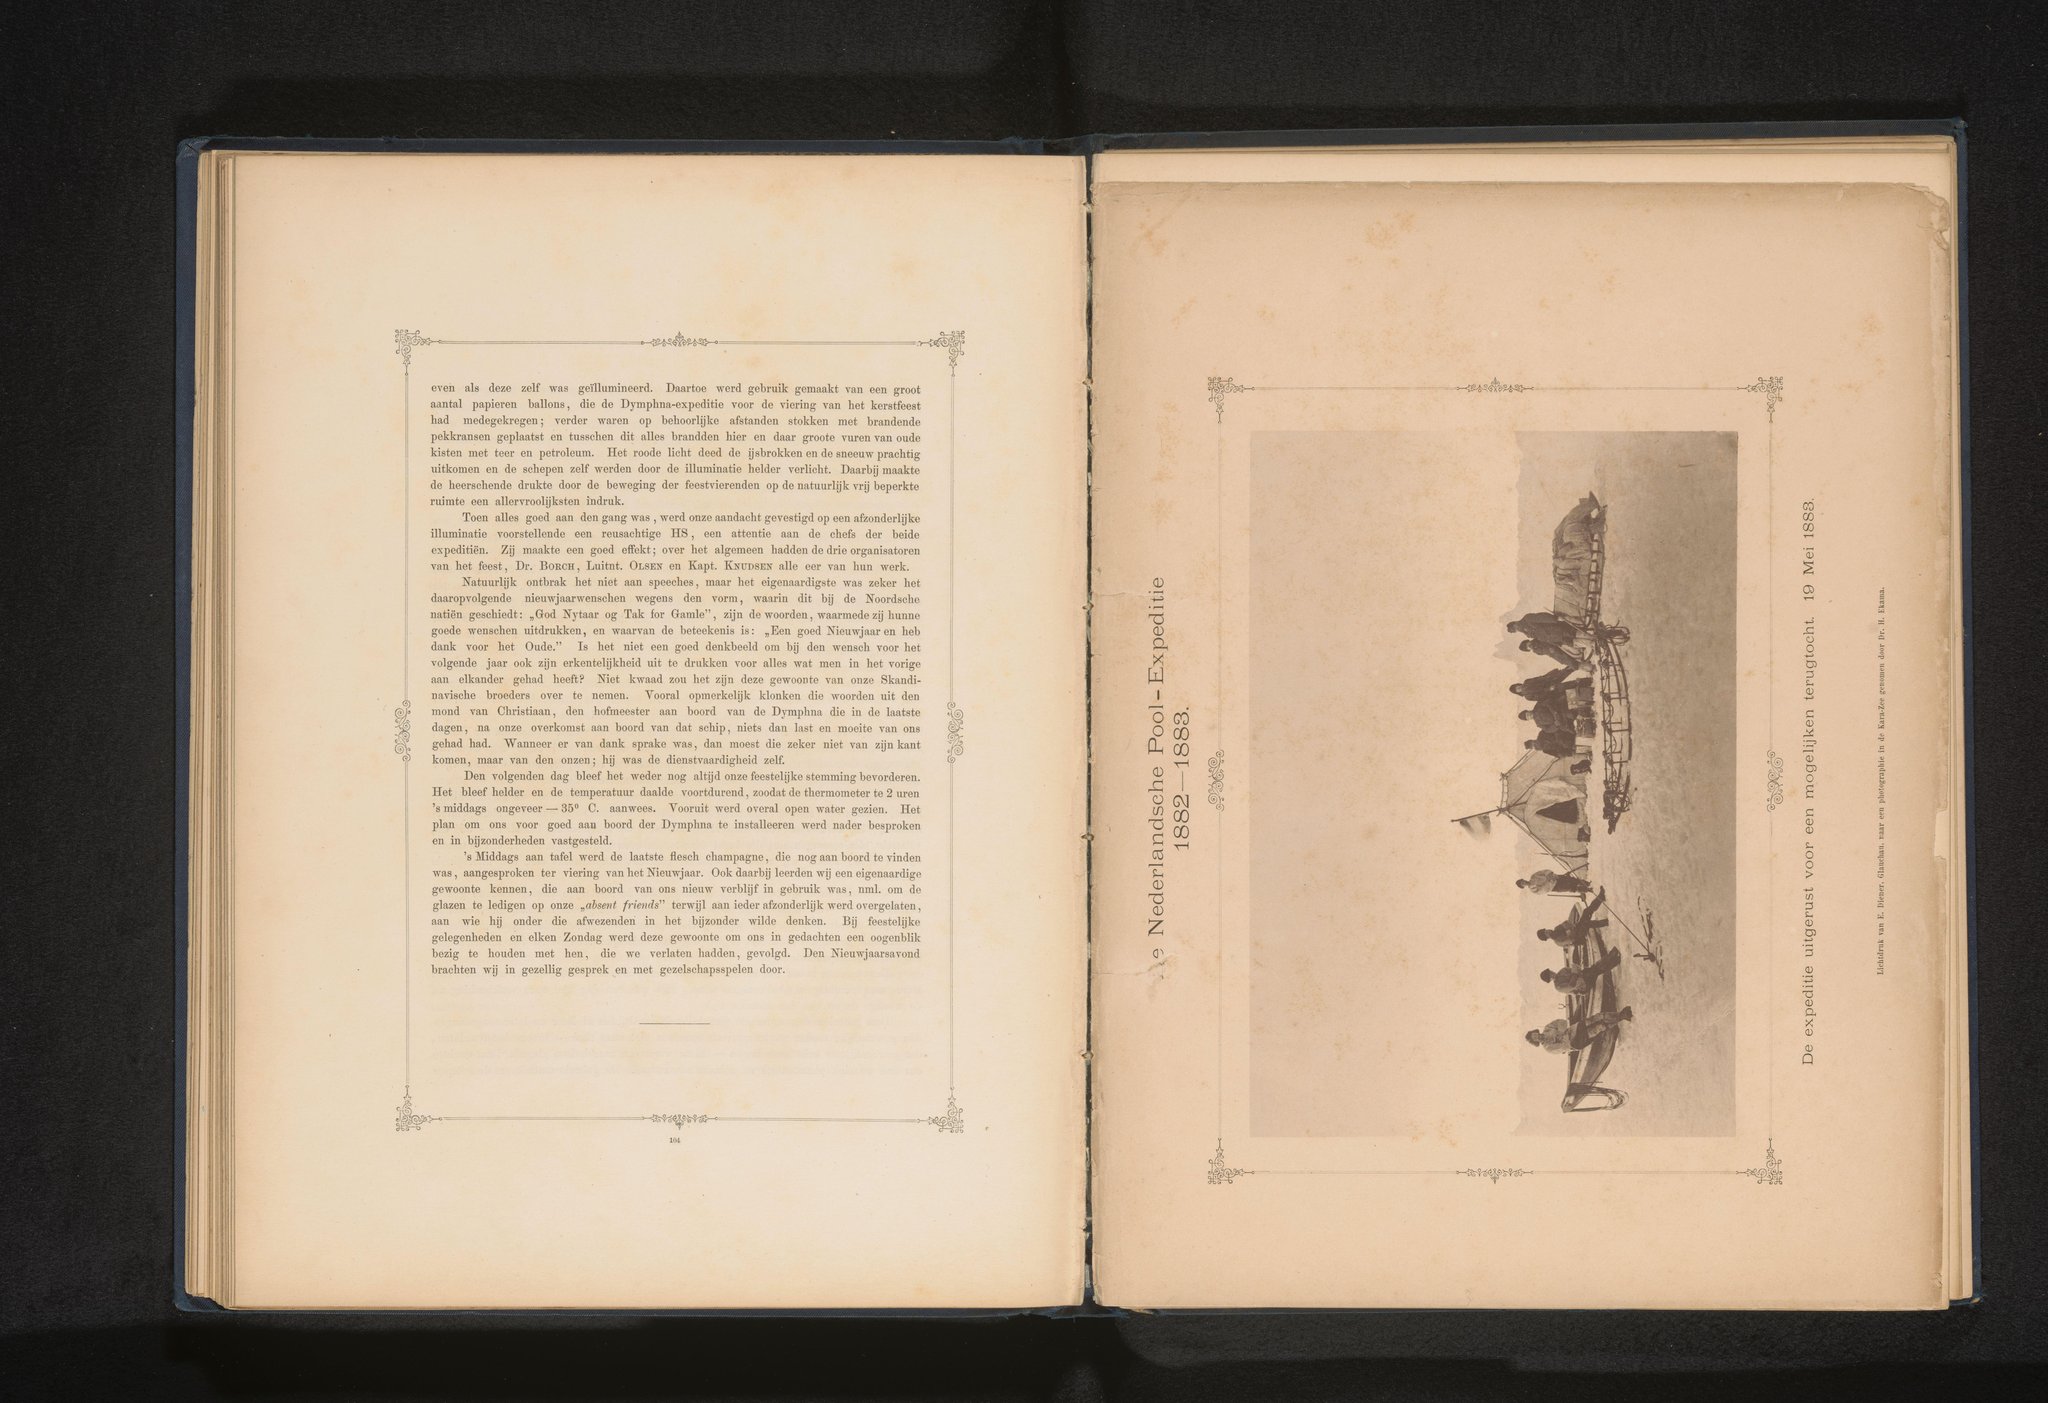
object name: page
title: De expeditie uitgerust voor een mogelijken terugtocht. 19 Mei 1883.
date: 1881-1886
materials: paper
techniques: photograph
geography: glauchau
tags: icefield, landscapes in polar regions, anonymous historical persons portrayed in a group, in a group-portrait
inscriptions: inscription: ‘De Nederlandsche Pool-Expeditie 1882-1883’